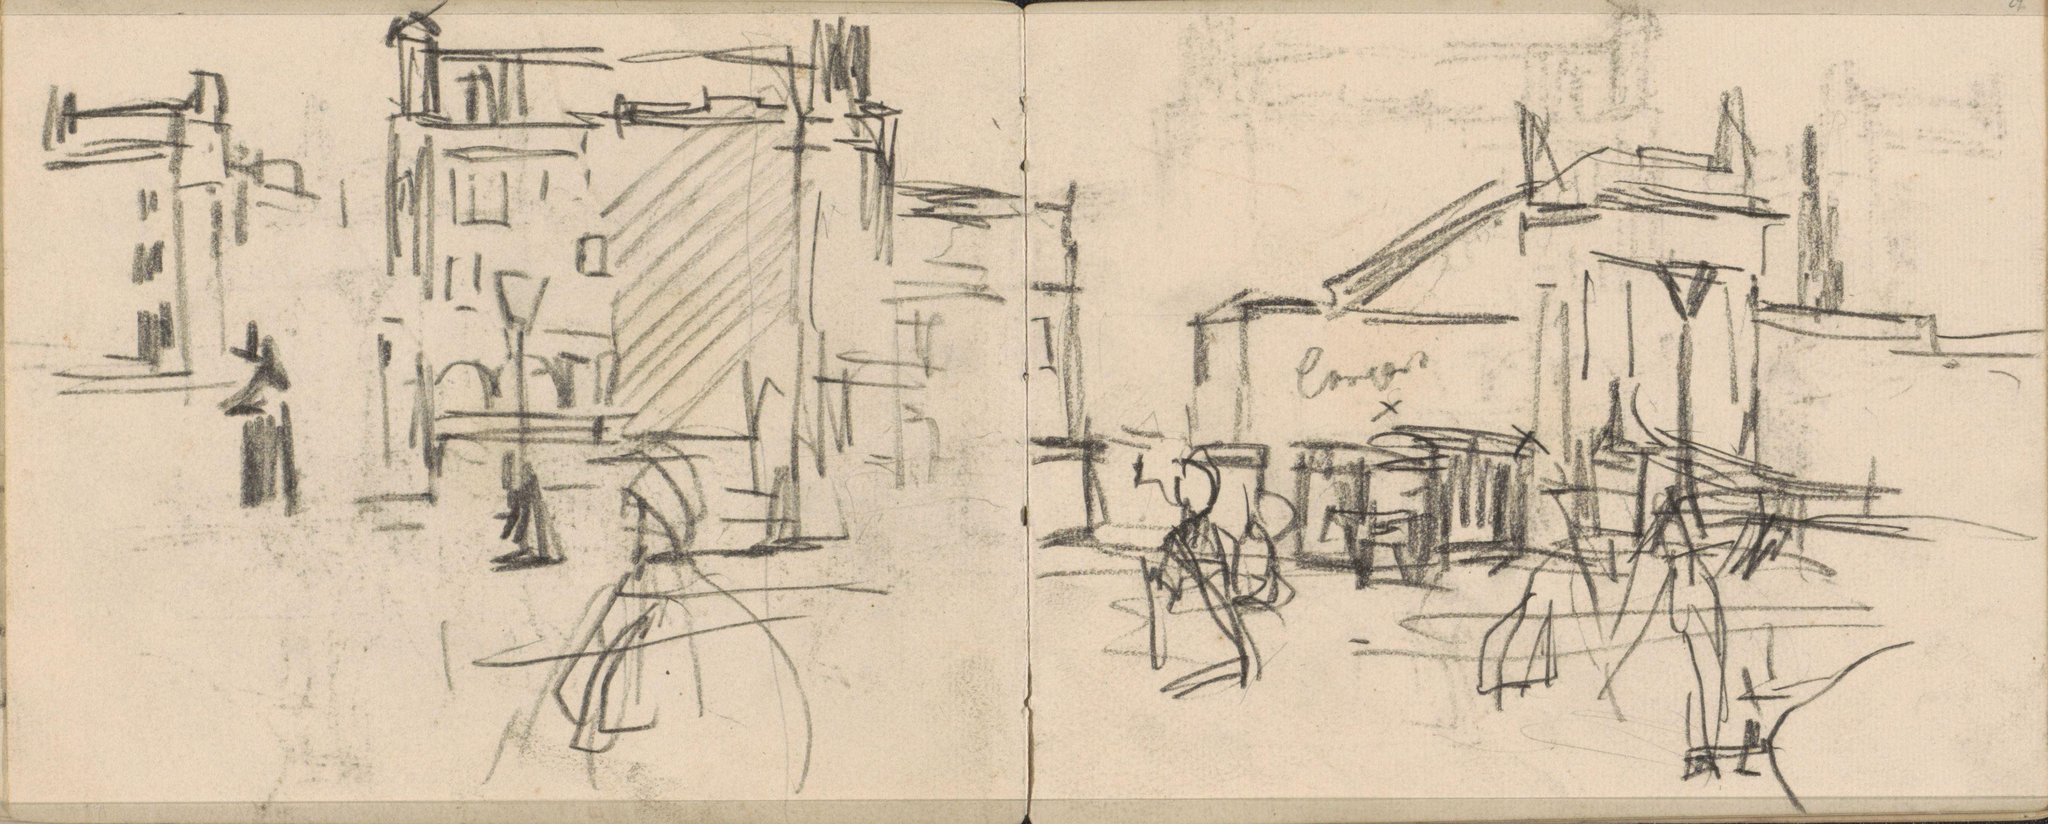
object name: sketchbook leaf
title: Gezicht op de Dam te Amsterdam met Café Bisschop en de Beurs van Zocher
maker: george hendrik breitner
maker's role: draughtsman, painter, print maker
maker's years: 1857-1923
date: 1893-1899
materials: chalk, paper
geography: amsterdam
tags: diligence, omnibus, horse-tram, urban housing, square, place, circus, etc. (+ city(-scape) with figures, staffage), parts of church exterior and annexes: tower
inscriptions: annotation: ‘[...]’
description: Rechts de toren van de Oude Kerk. Vooraan paardentrams. Pagina 23 en pagina 24 uit een schetsboek met 28 bladen.